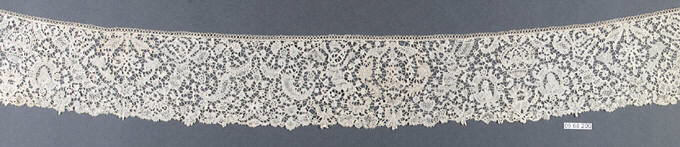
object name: strip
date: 1701-1733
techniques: lace